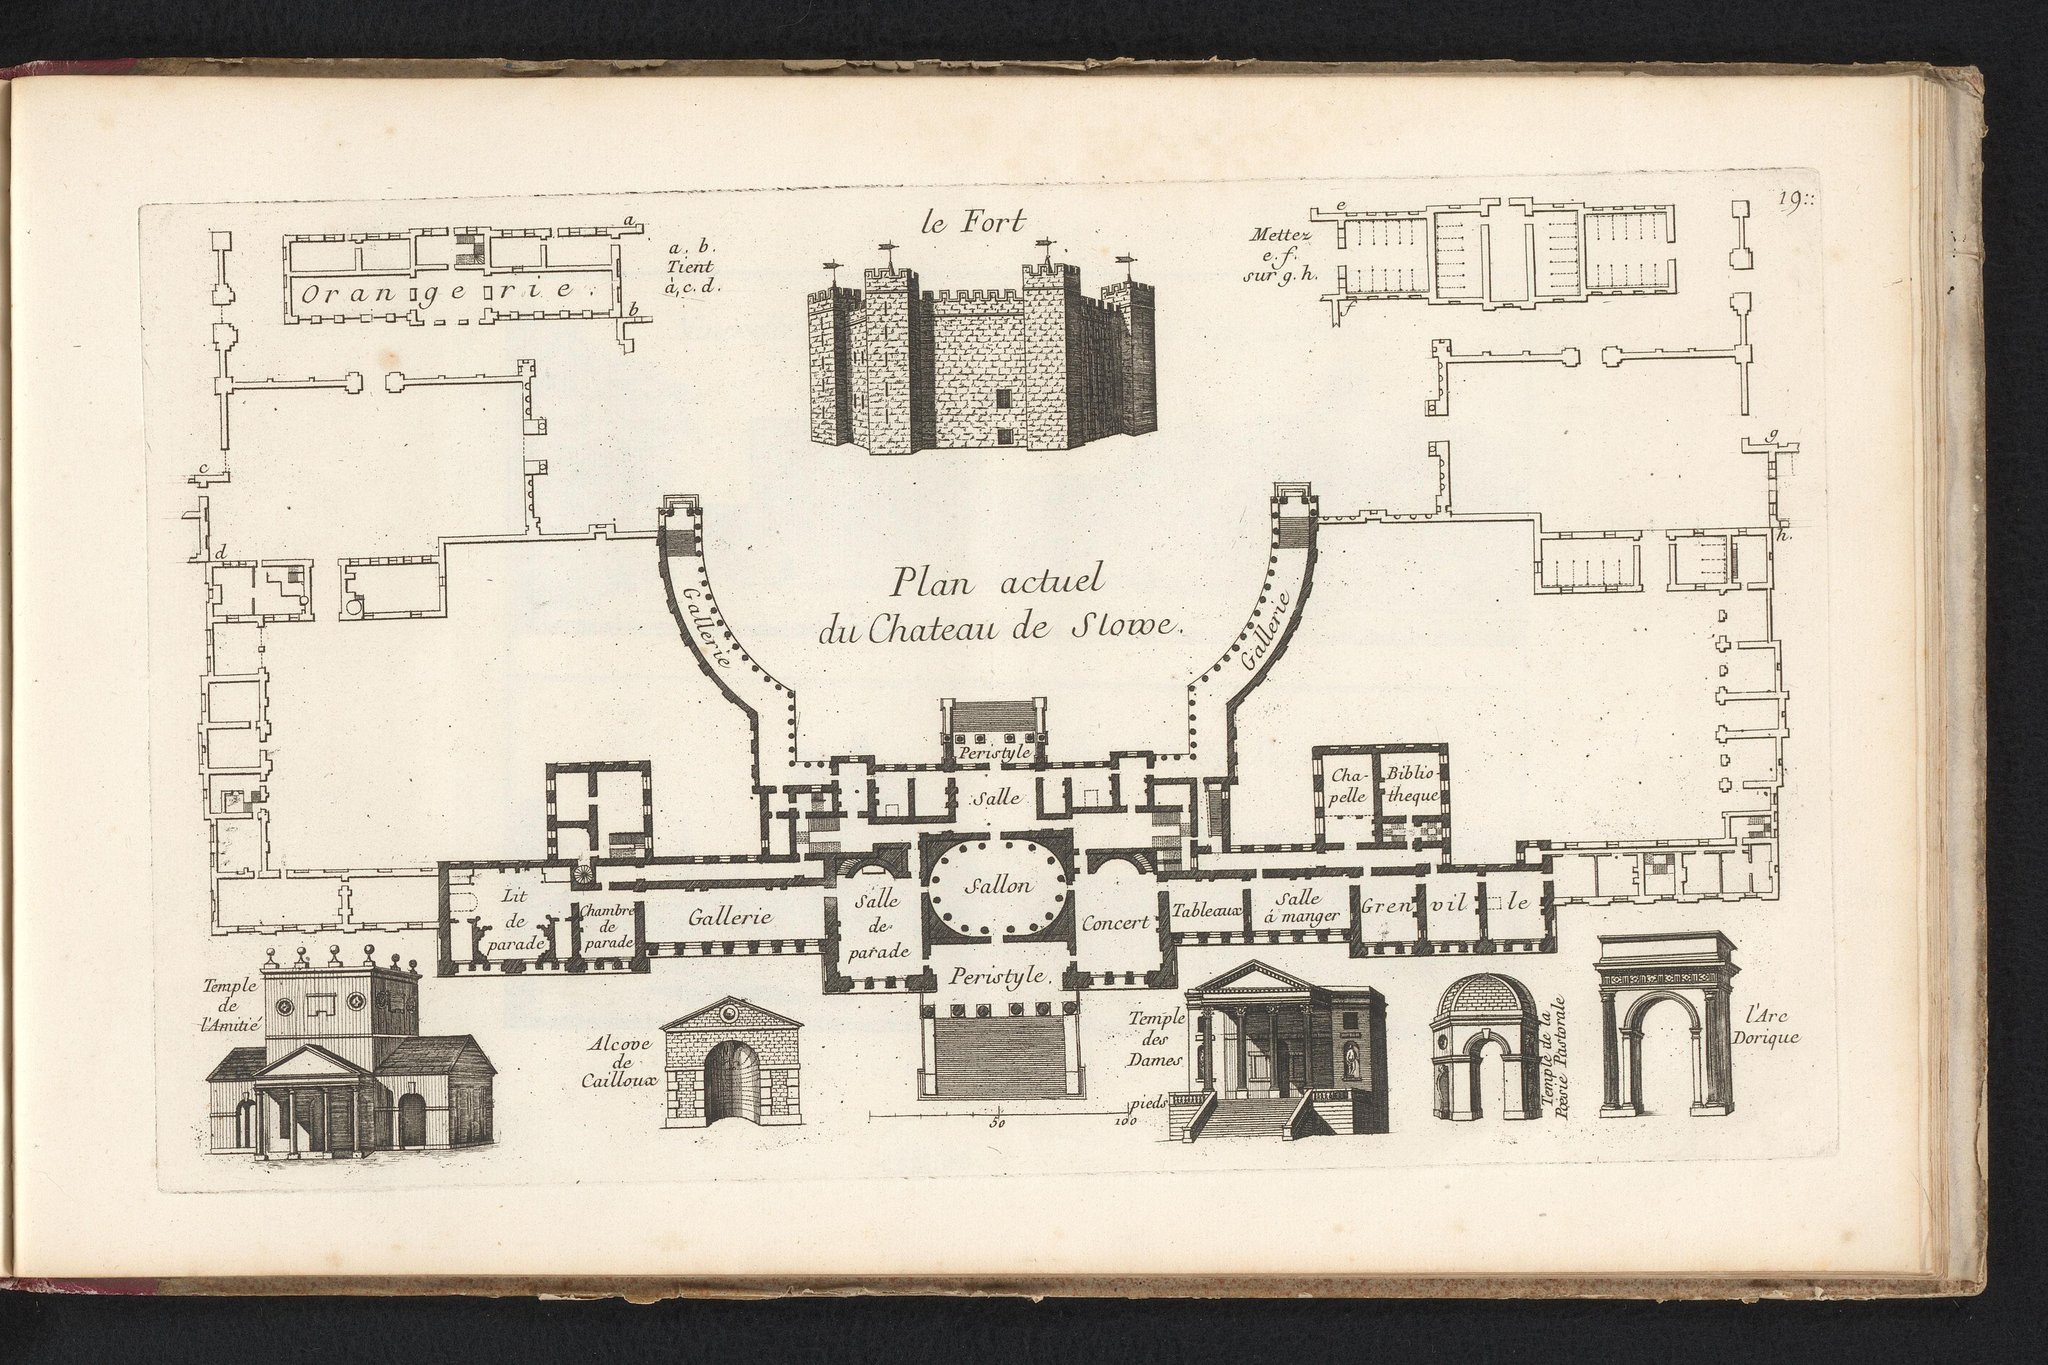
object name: print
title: Plan actuel du Chateau de Stowe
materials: paper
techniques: engraving, etching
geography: paris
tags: castle, plan ~ architecture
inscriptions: collector's mark: Lugt 2228, collector's mark: Lugt 2760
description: De serie 'Jardins anglo-chinois à la mode' verscheen in totaal in 21 zogeheten 'cahiers' (afleveringen). De huidige prent komt uit het vierde 'cahier'. Het Rijksmuseum Amsterdam bezit drie banden met daarin in totaal zes 'cahiers' van deze reeks. In de documentatie wordt verwezen naar een in de bibliotheek van het Rijksmuseum Amsterdam aanwezige facsimile van het complete werk.